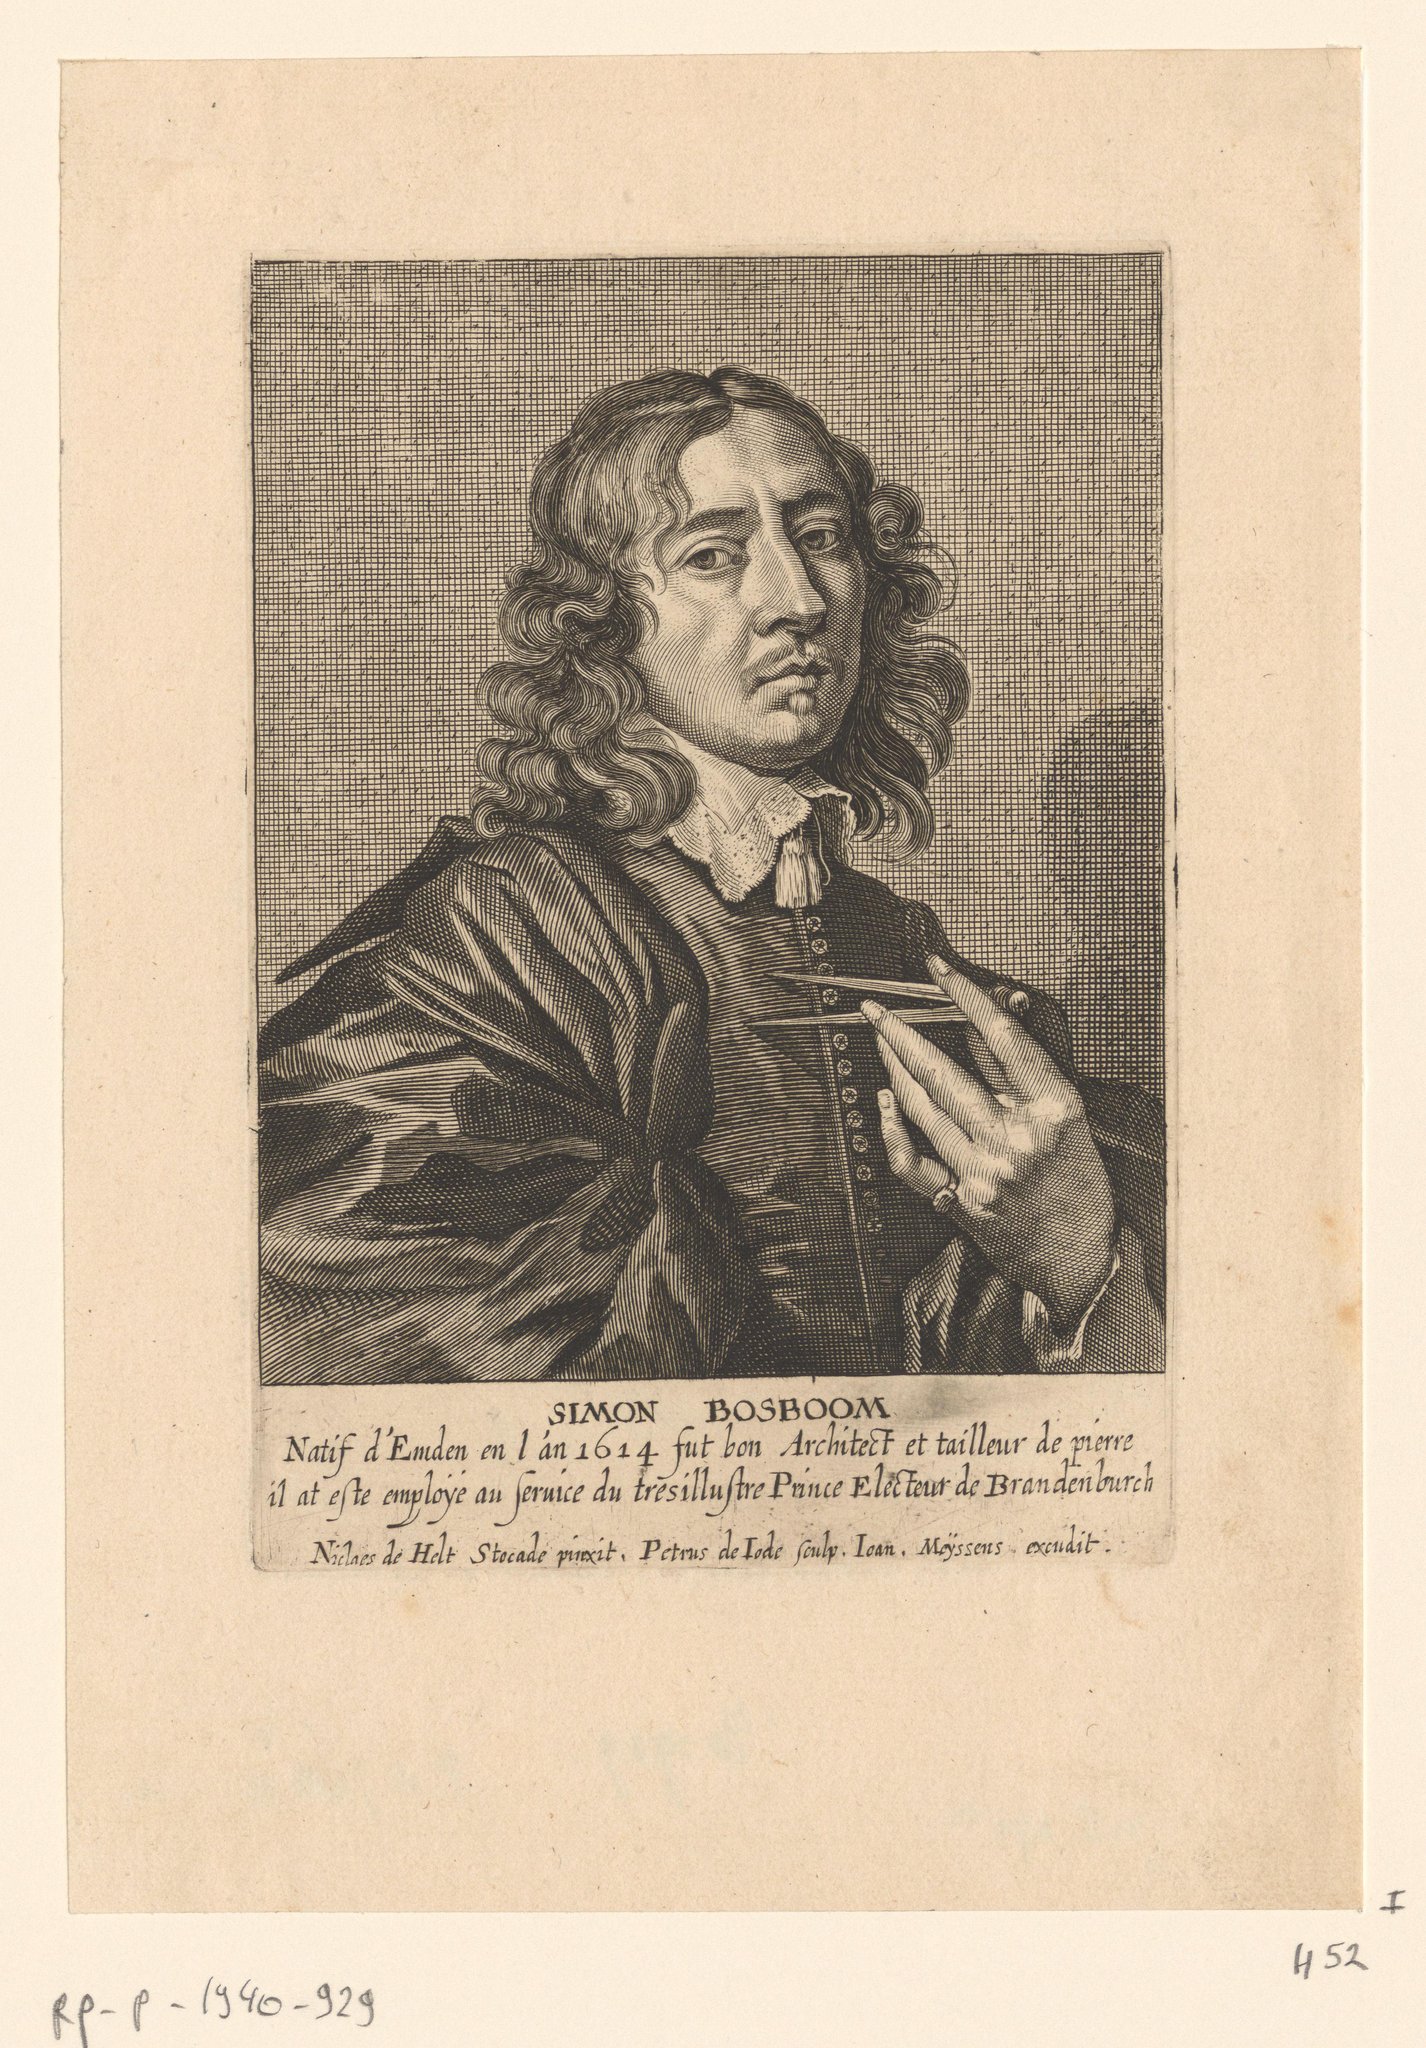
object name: print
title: Portretten van kunstenaars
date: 1649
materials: paper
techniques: engraving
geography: antwerp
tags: historical persons, compasses, portrait, self-portrait of architect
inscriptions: collector's mark: Lugt 2760, collector's mark: Lugt 2228